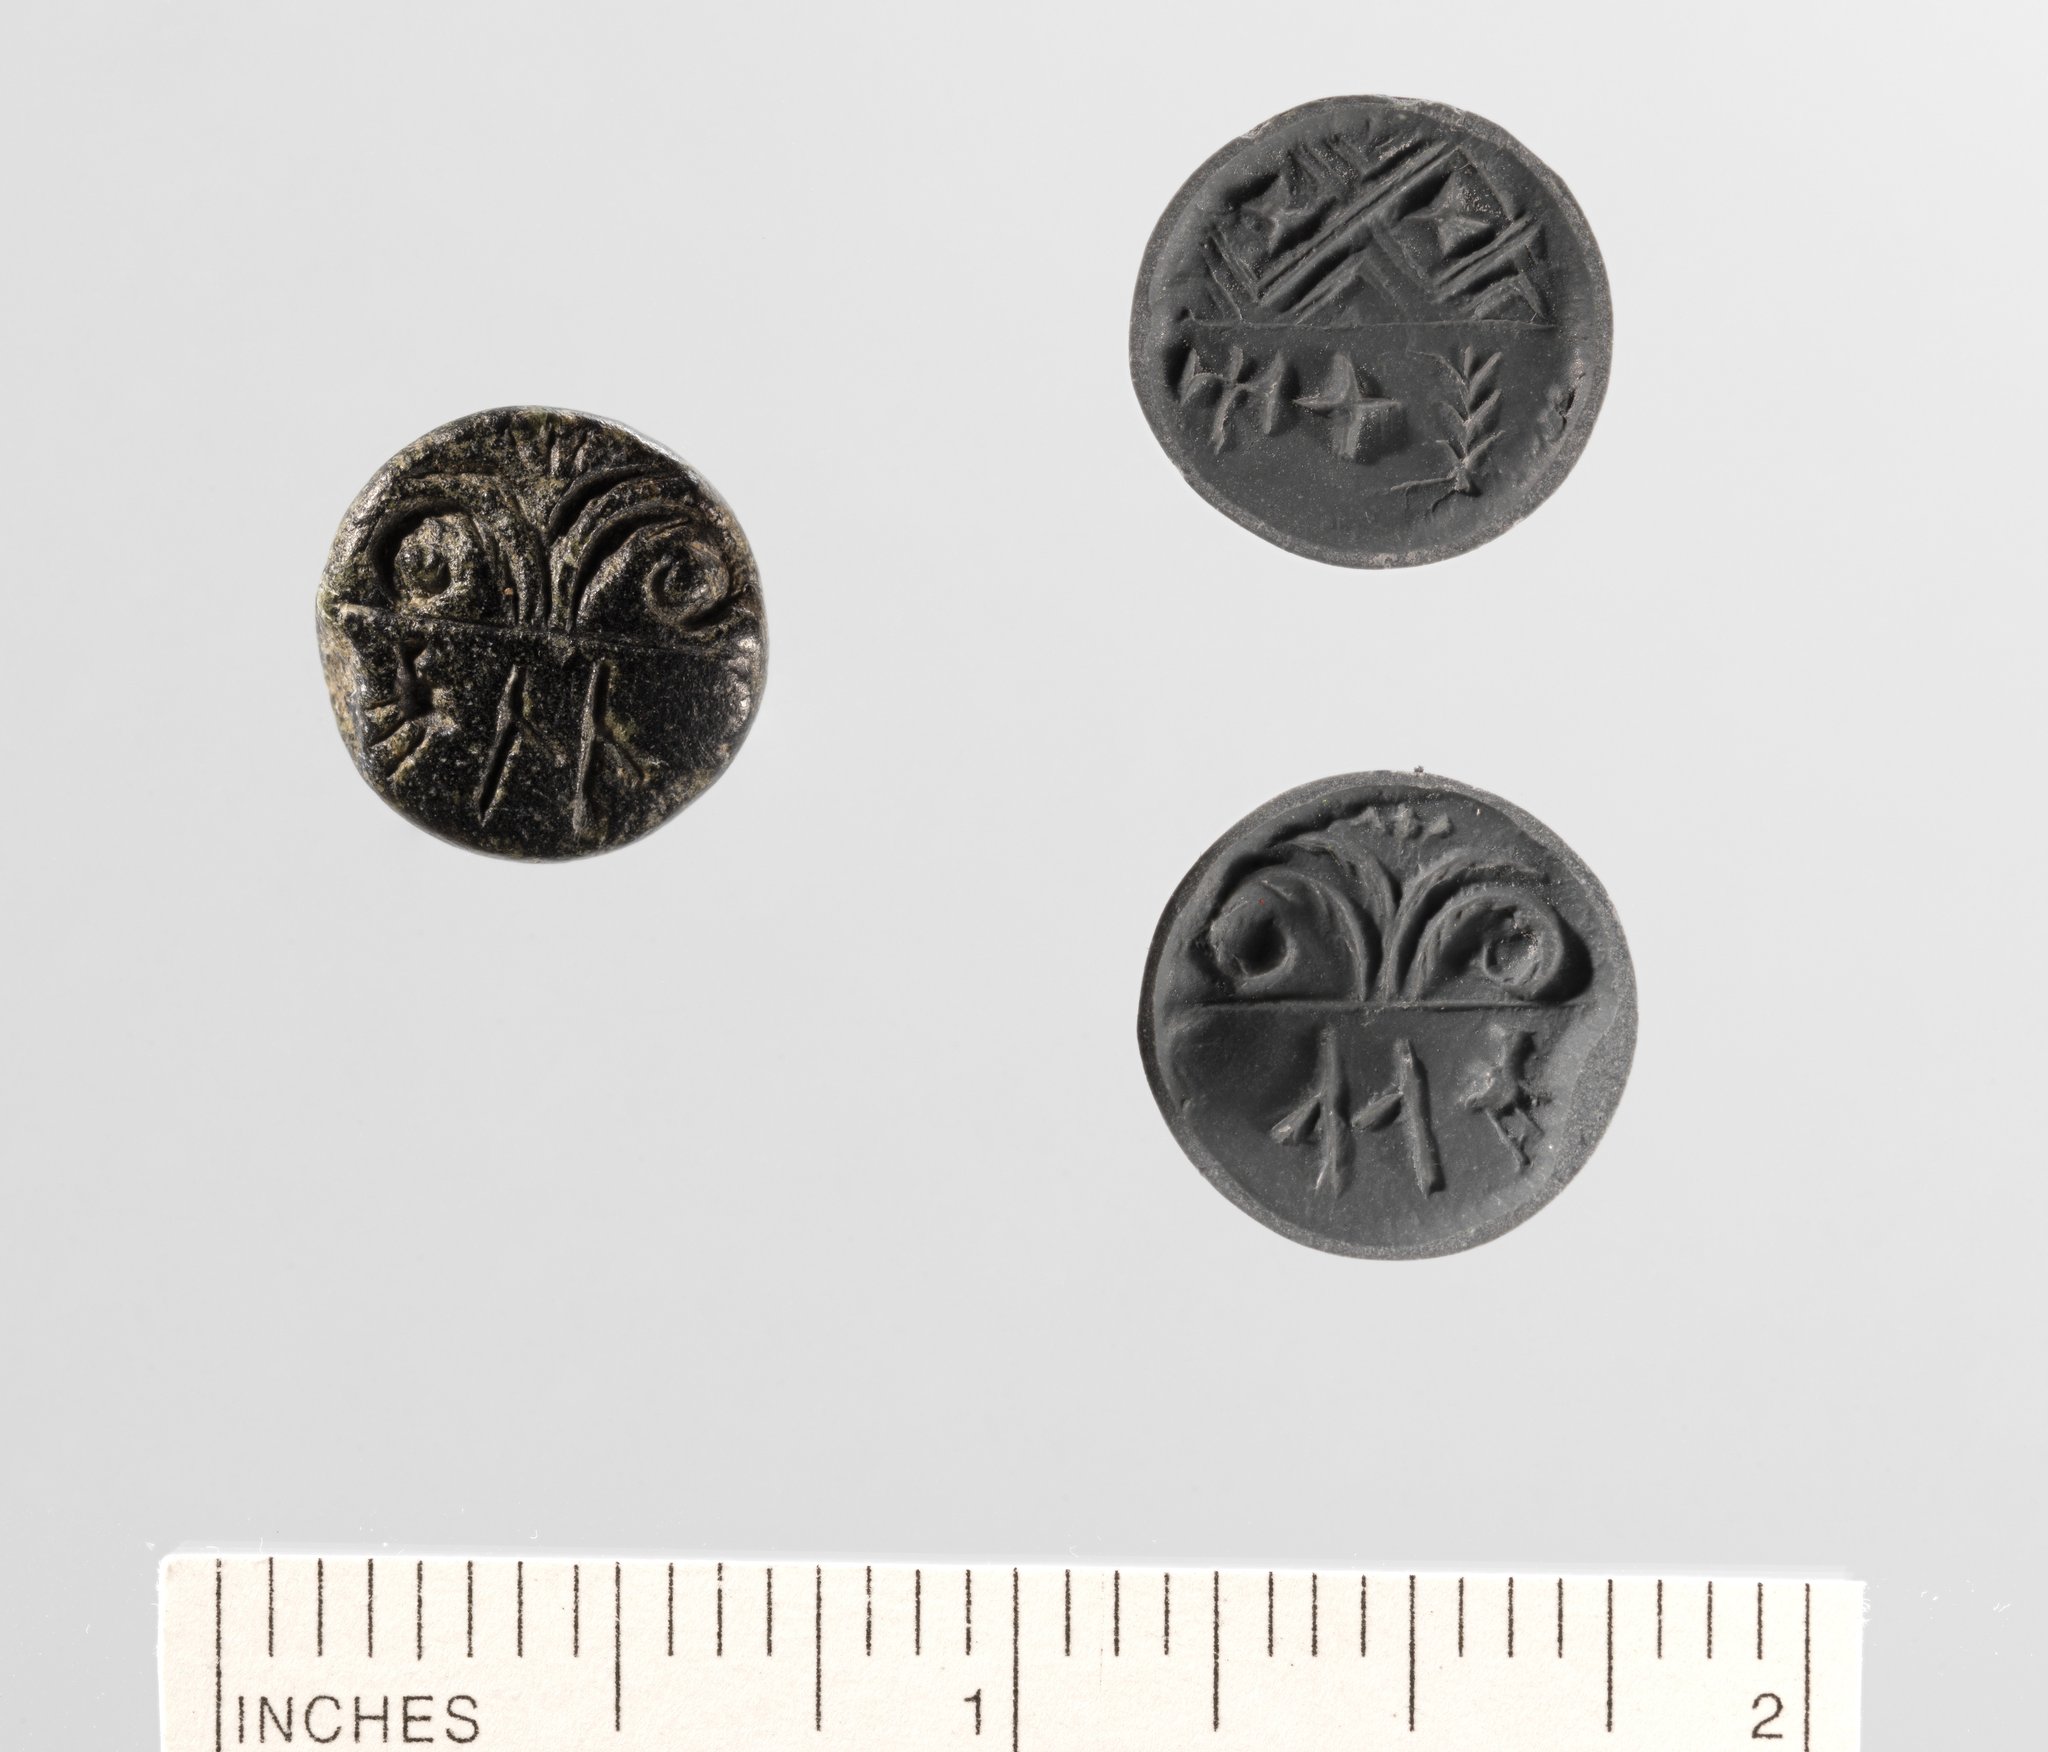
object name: reel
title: Steatite Reel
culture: minoan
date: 1700-1500 BCE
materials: stone